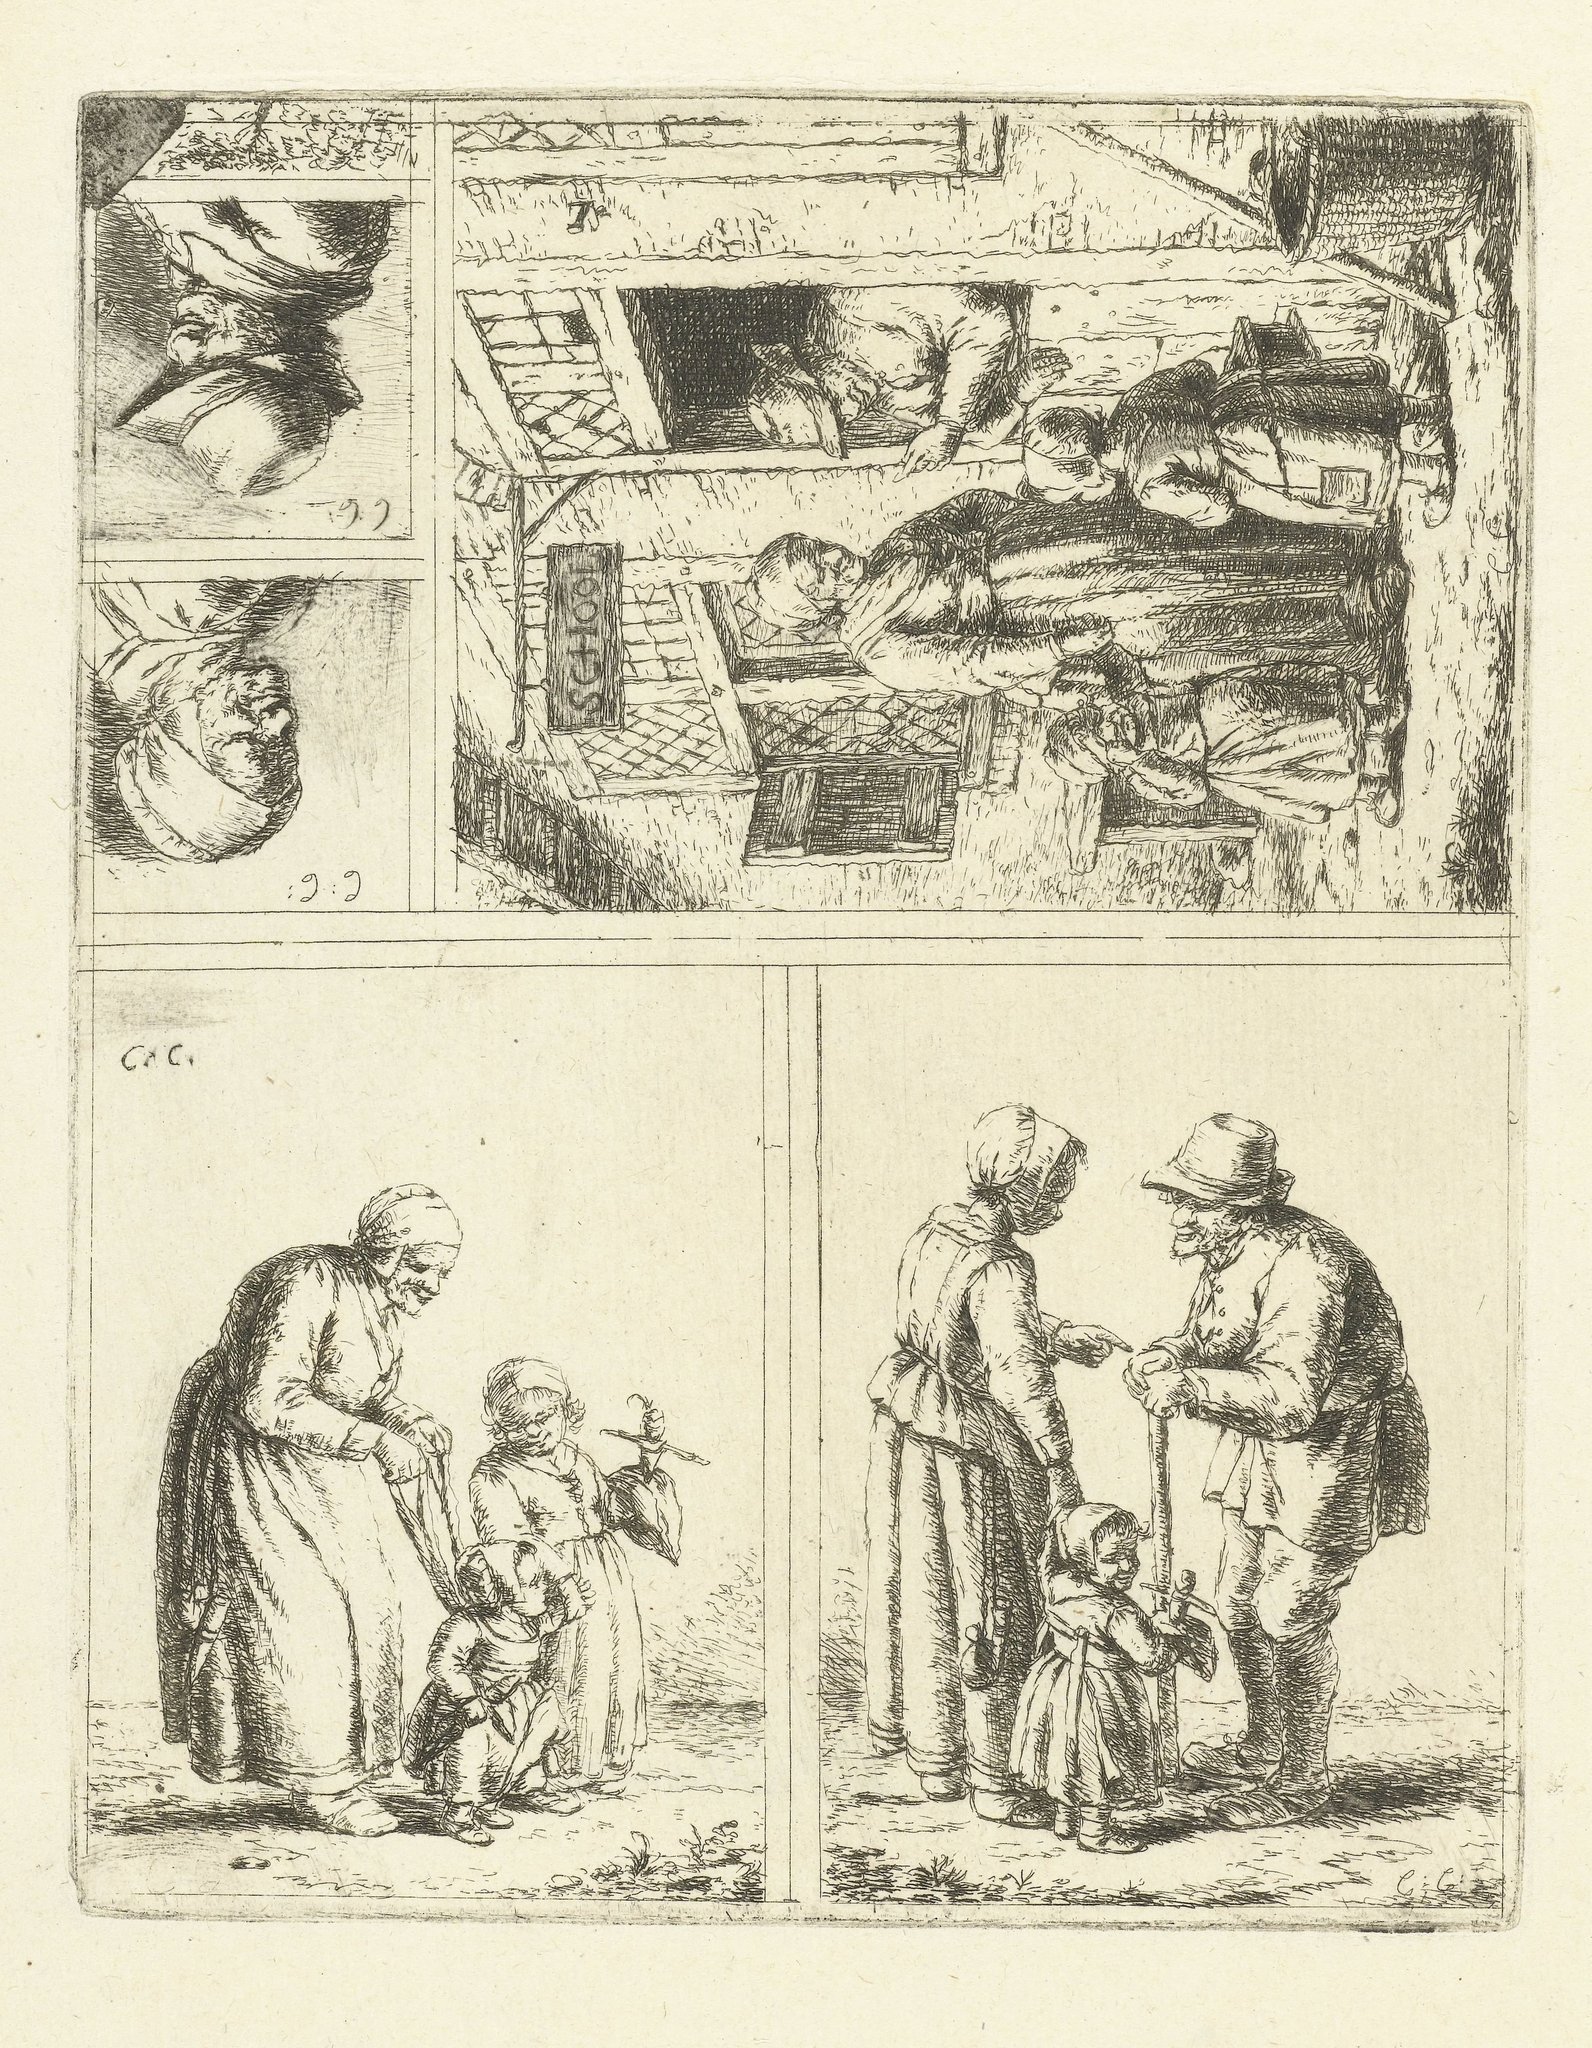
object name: print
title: Vijf voorstellingen van het gezinsleven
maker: christina chalon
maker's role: draughtsman, print maker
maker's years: 1748-1808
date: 1758-1808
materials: paper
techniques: etching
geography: leiden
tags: pipe ~ tobacco, farmers, scholastic education, tuition (+ teacher, professor), (playing with) dolls, scholastic education, tuition (+ building ~ education, tuition), being brought to school, first school-day, implements for learning to walk, go-cart, mother and child(ren), woman and child(ren) (family group) (with number of children), morphology of human expression (+ old female (human being)), learning to walk, the first steps, morphology of human expression (+ adult male (human being))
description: De eerste voorstelling toont een vrouw die haar twee kleine kinderen naar school brengt. De schoolmeester staat in de portiek en wenkt de kinderen naar binnen. Het jongste kind wil niet en huilt. Boven deze voorstelling twee portretten. Een van een onbekende man met een pijp. Buste naar rechts. Een portret van een onbekende oude vrouw. Buste naar links. De vierde voorstelling toont een moeder die haar kind leert lopen door middel van een tuigje en een leiband. Het meisje haar zusje helpt haar. Beide kinderen hebben een pop vast. In de vijfde voorstelling is een vrouw in gesprek met een oude boer. Haar dochtertje houdt een popje vast.